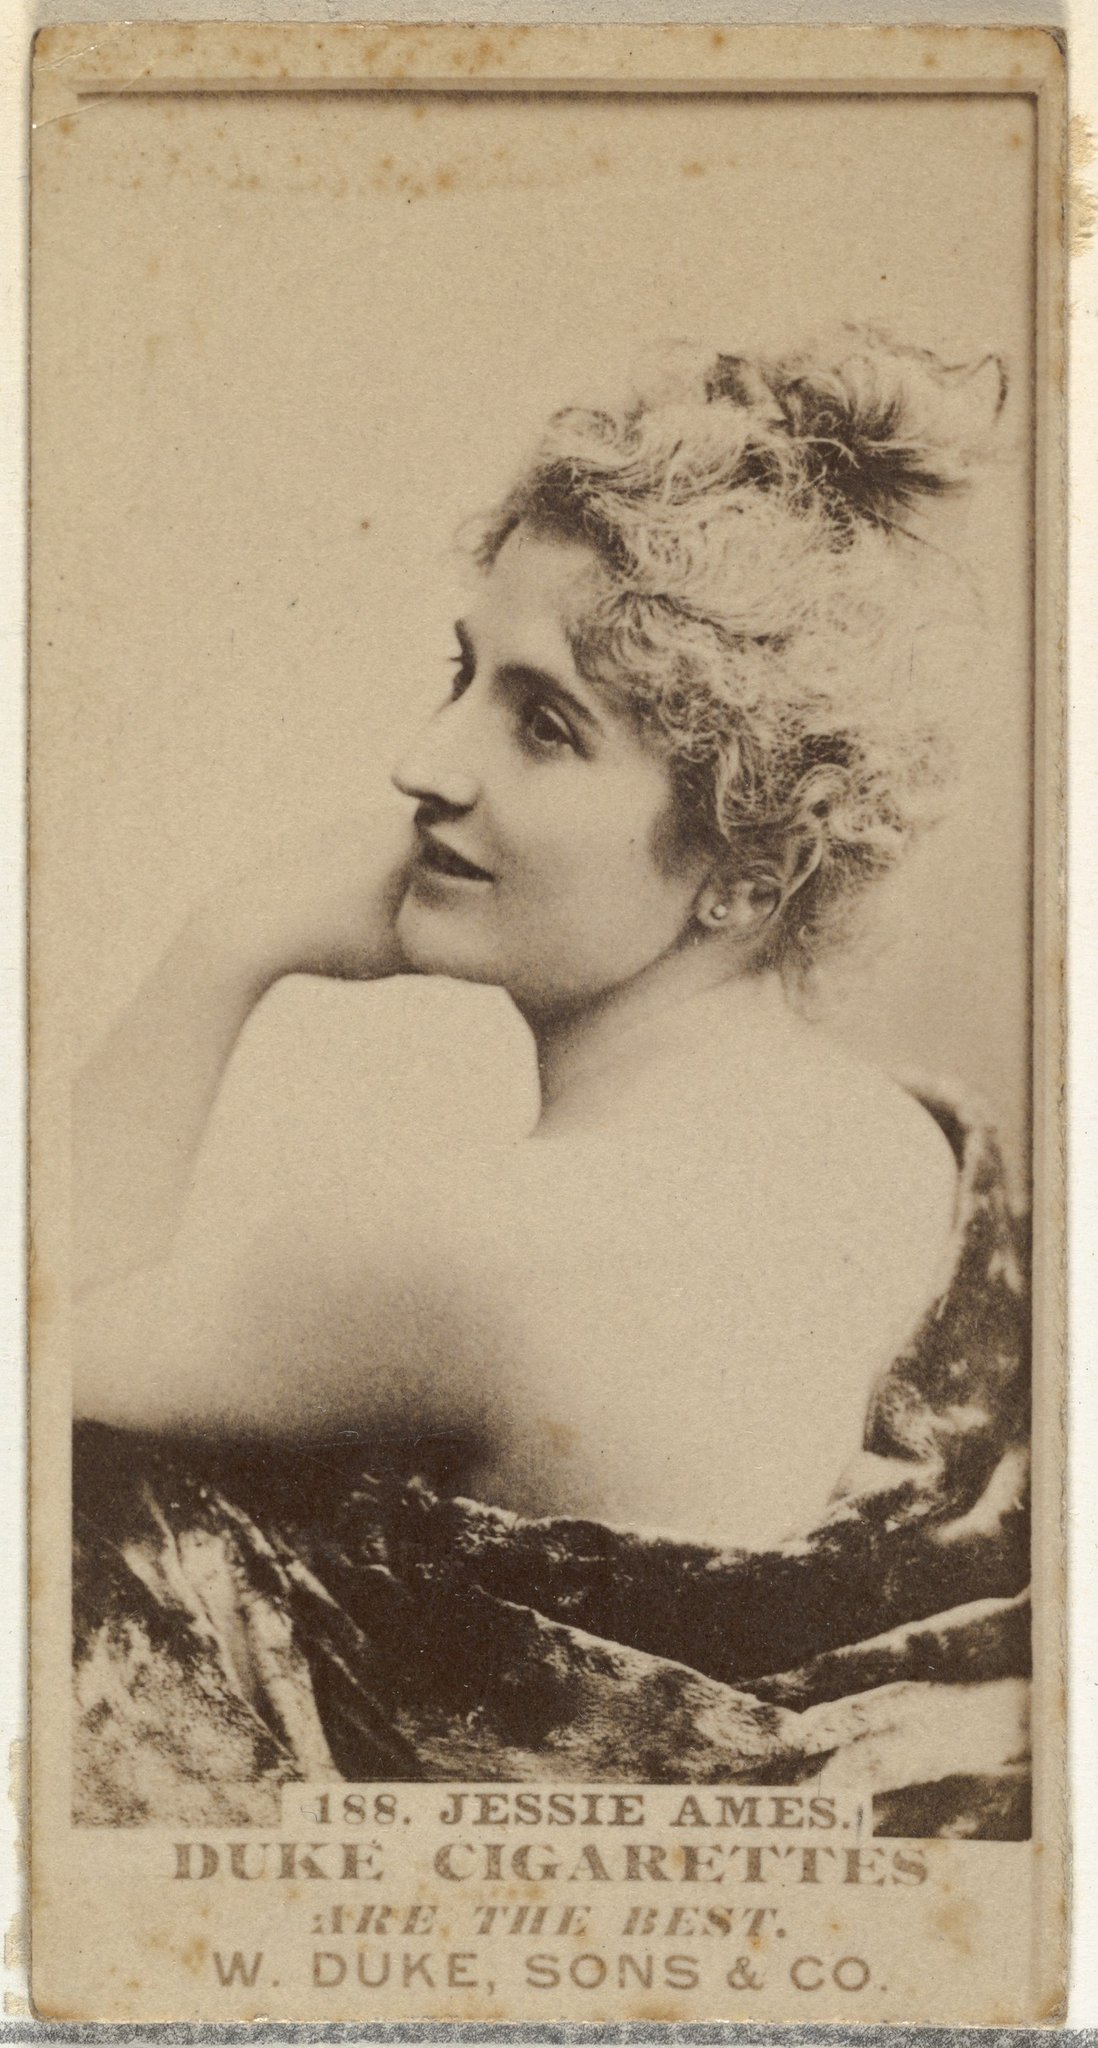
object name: photograph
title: Card Number 188, Jessie Ames, from the Actors and Actresses series (N145-7) issued by Duke Sons & Co. to promote Duke Cigarettes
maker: w. duke, sons & co.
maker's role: publisher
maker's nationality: american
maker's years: 1870-1920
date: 1880-1889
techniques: albumen silver print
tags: portraits,women,actresses